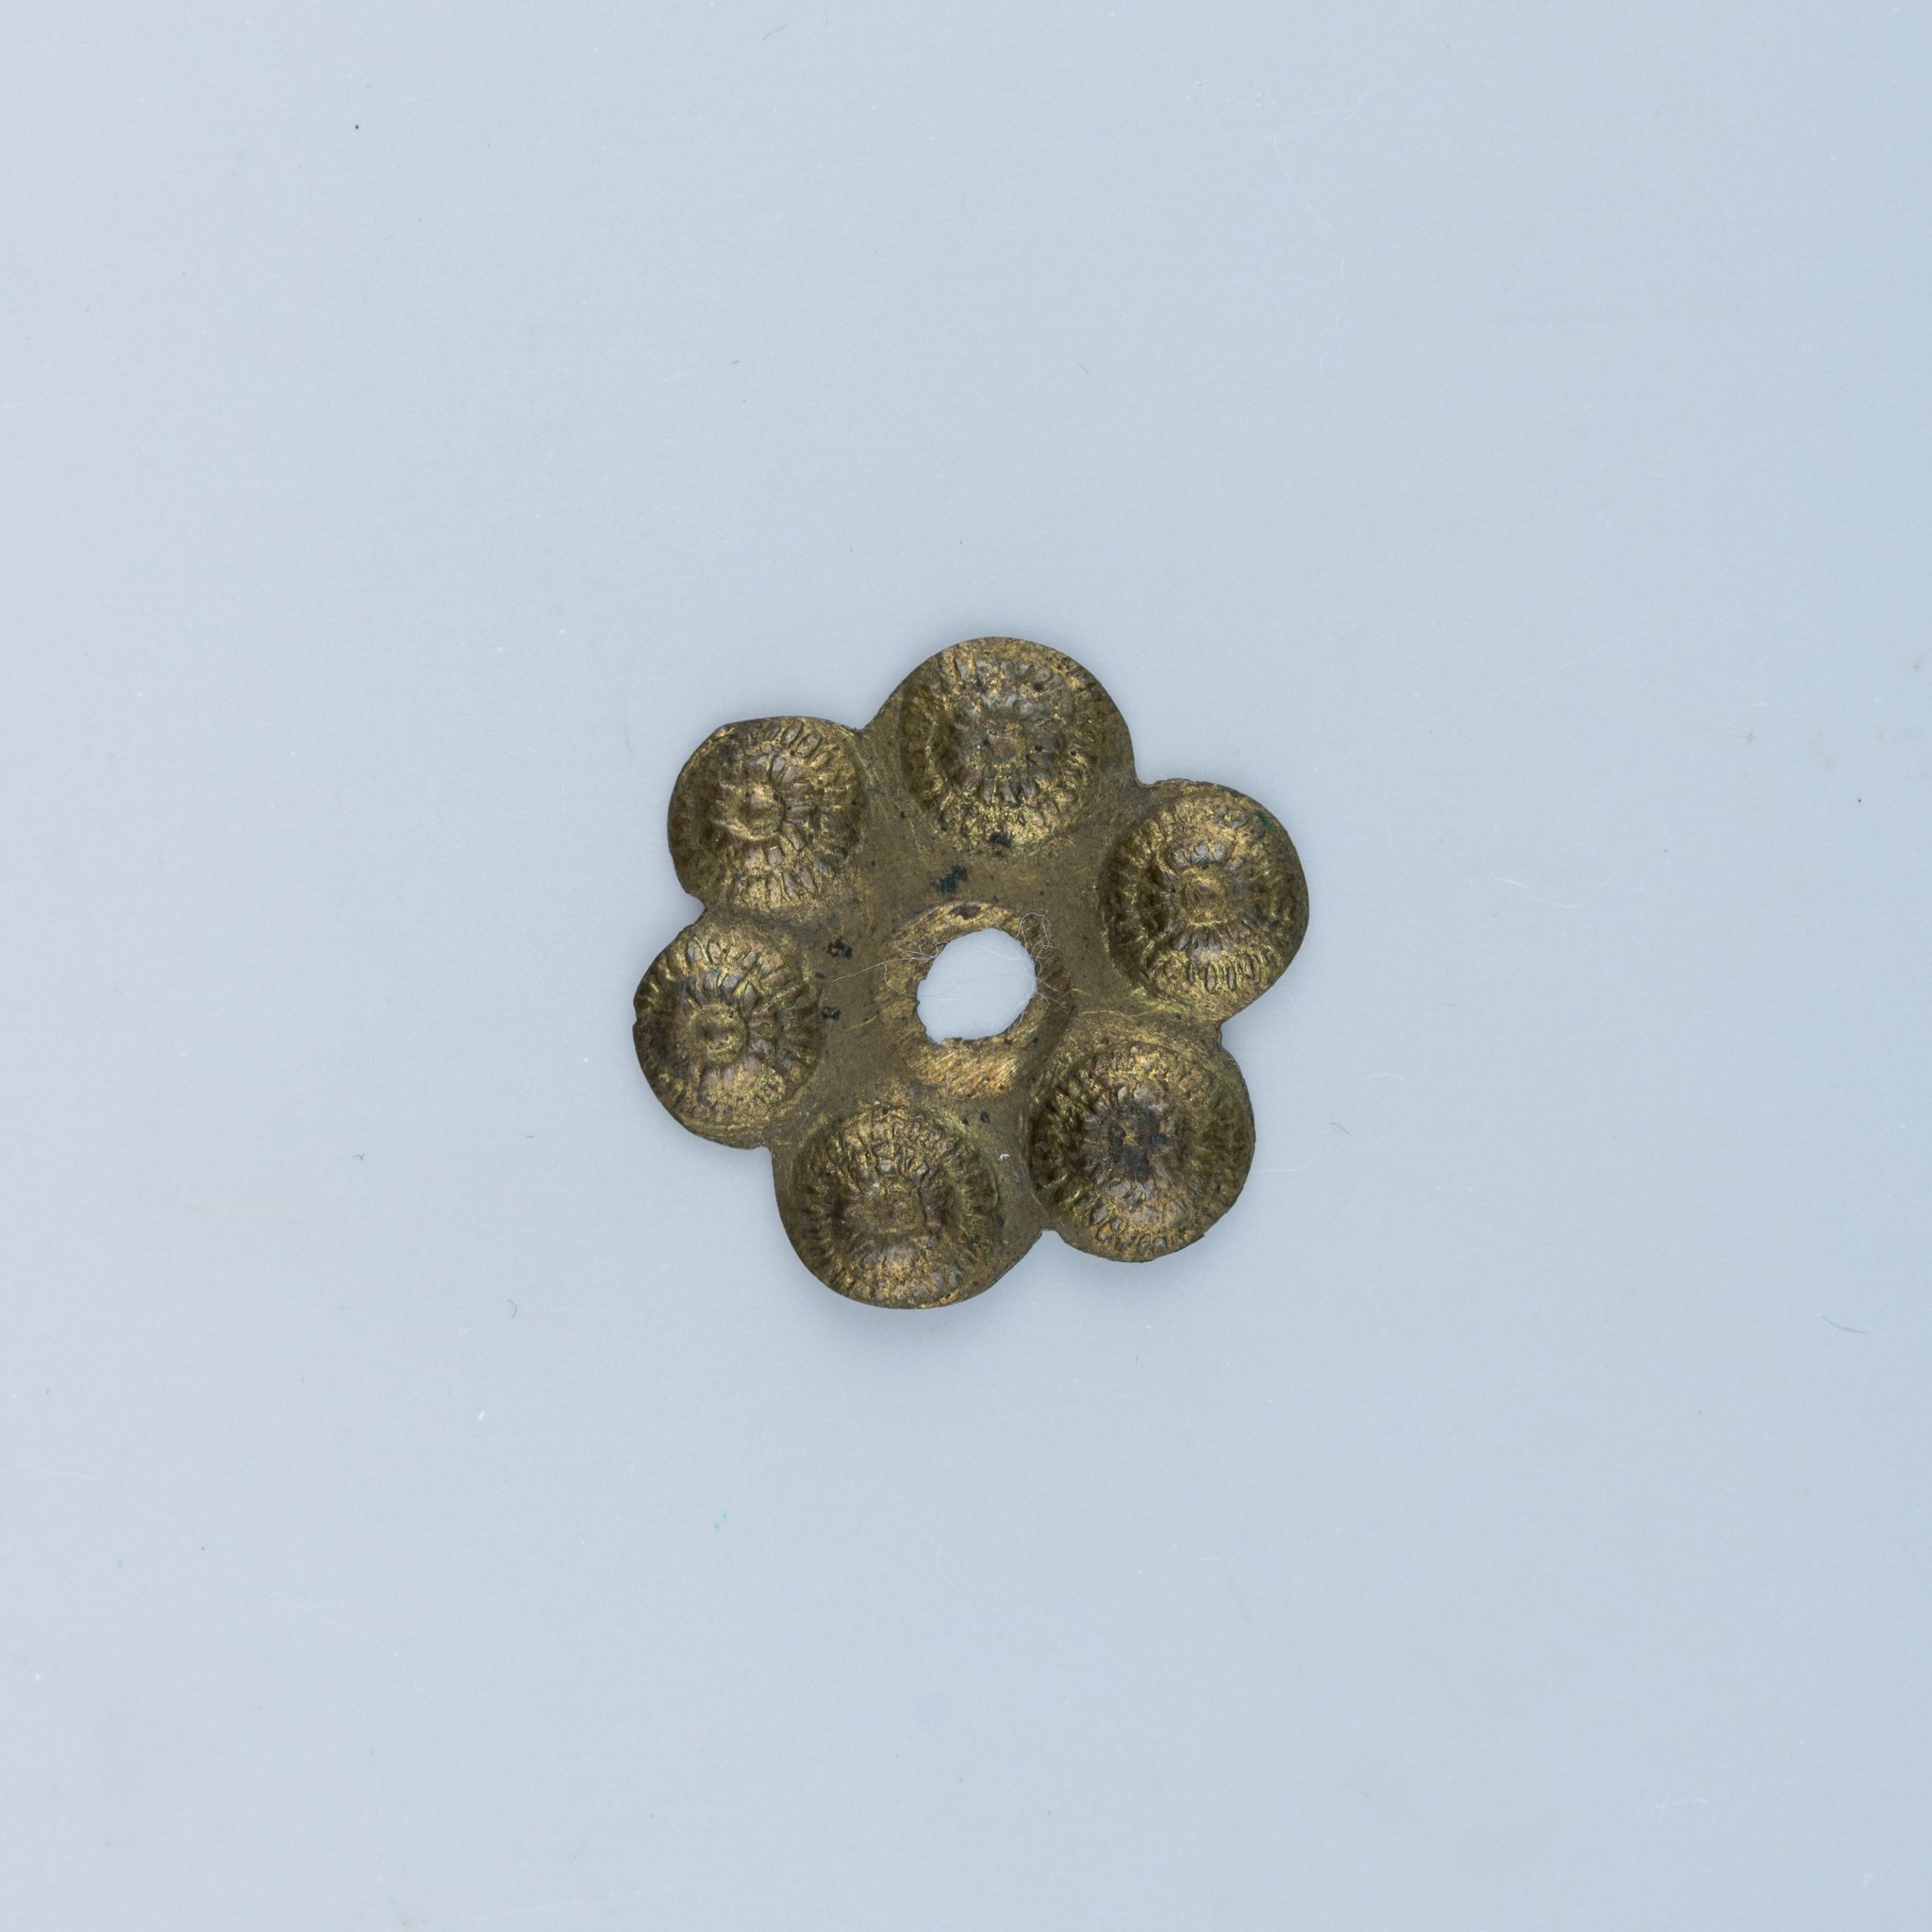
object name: rosette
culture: french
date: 1540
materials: brass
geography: france